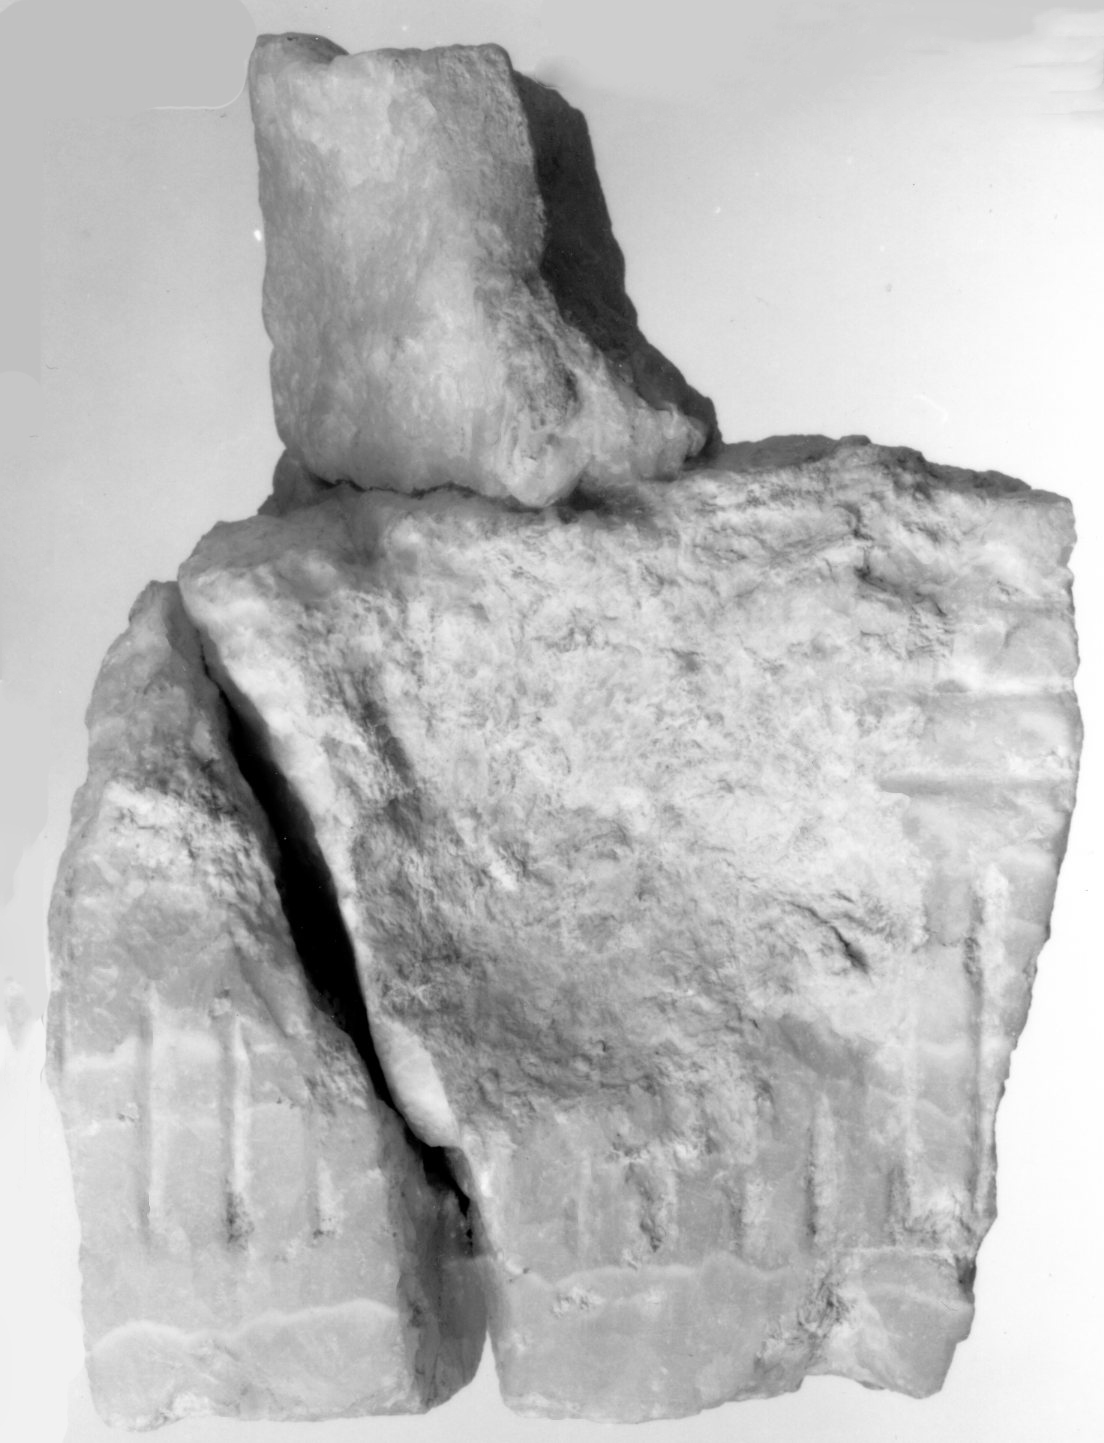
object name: canopic chest, siptah, outer decoration, palace facade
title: Fragment of the Outer Decorated Surface of Siptah's Canopic Box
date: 1194-1188 BCE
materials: stone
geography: egypt